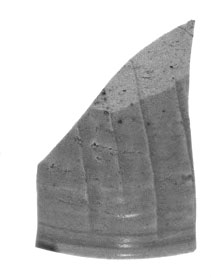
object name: fragment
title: Fragment of a Bowl (Study Collection)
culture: chinese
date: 901-1000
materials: ceramic glaze, ceramic, glaze